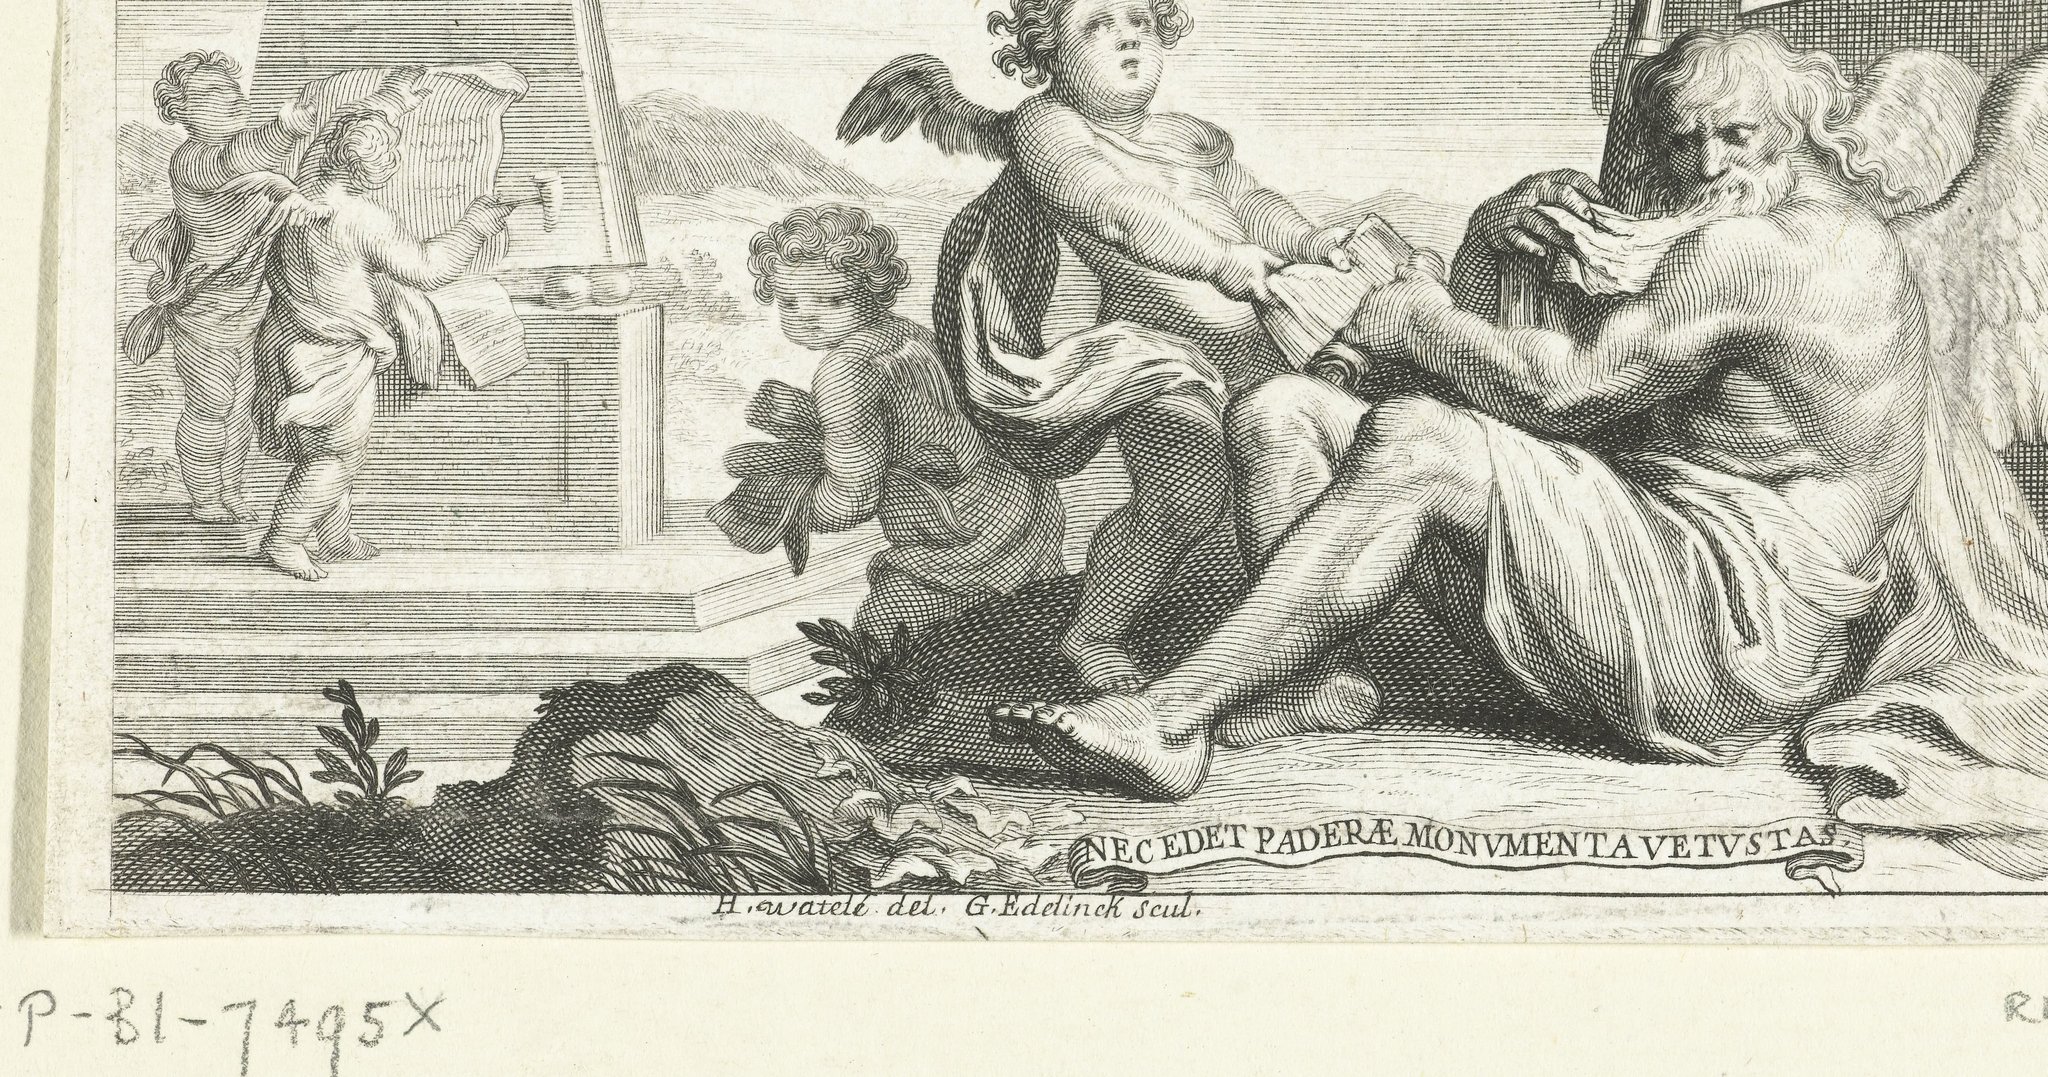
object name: print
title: Putti ontnemen Vader Tijd geschriften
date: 1666-1707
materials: paper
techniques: engraving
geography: france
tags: father time, man with wings and scythe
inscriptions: collector's mark: Lugt 240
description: Twee putti ontnemen Vader Tijd geschriften, die twee andere putti op een obelisk bevestigen.